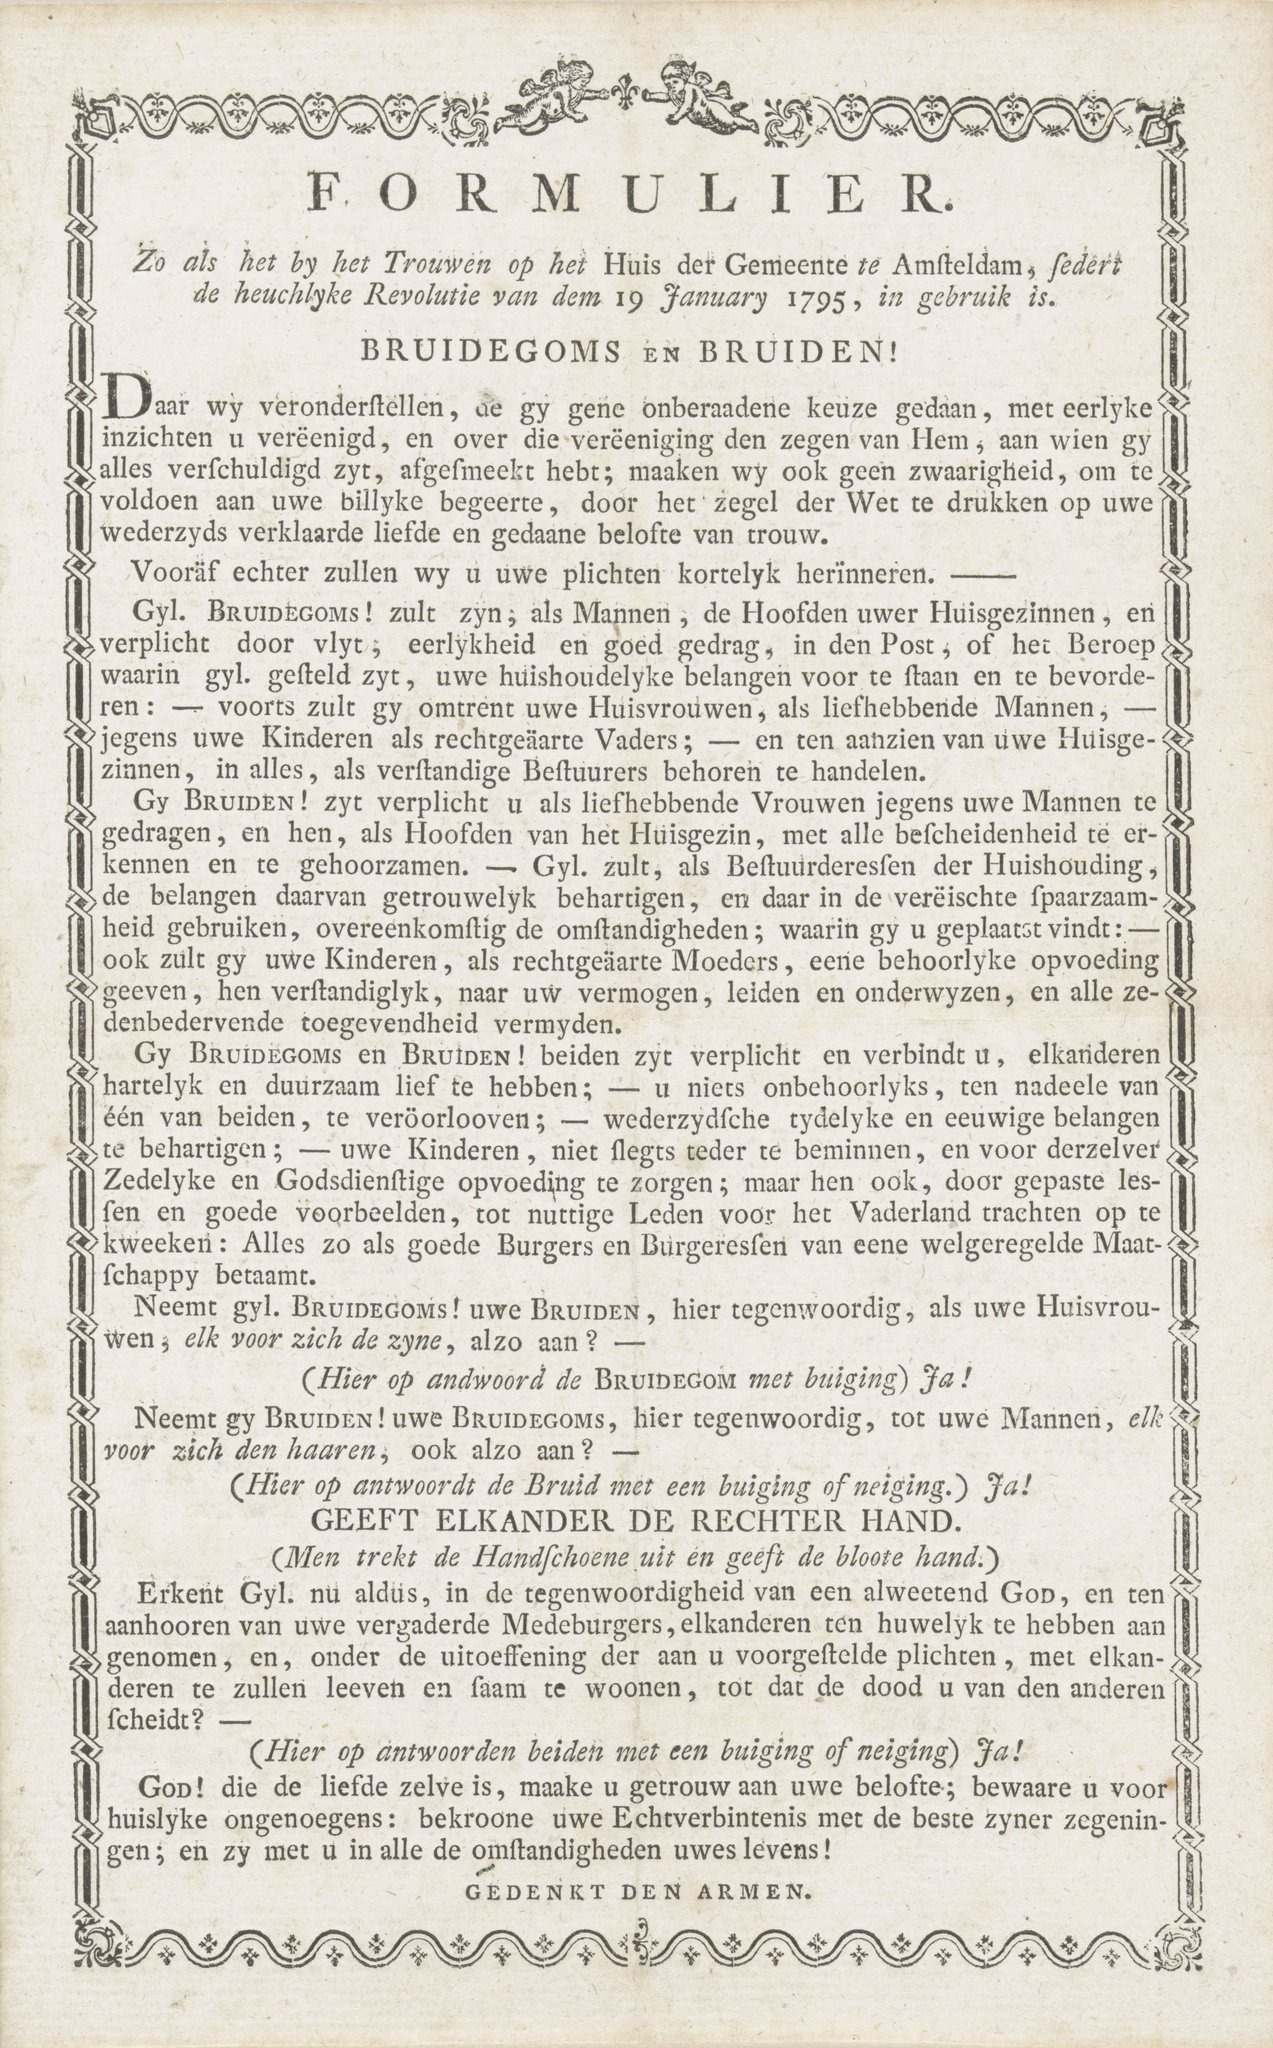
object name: text sheet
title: Formulier. Zo als het by het Trouwen op het Huis der Gemeente te Amsteldam, sedert de heuchlyke Revolutie van dem 19 January 1795, in gebruik is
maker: Anonymous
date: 1795-1796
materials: paper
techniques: letterpress printing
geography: amsterdam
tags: stadhuis van amsterdam (1655-1808), bataafse revolutie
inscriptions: collector's mark: Lugt 2228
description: Formulier met de nieuwe regels die van toepassing zijn bij het sluiten van een huwelijk op het stadhuis te Amsterdam sinds de revolutie van 19 januari 1795. Blad bedrukt op één zijde, tekst binnen kader van fileten.